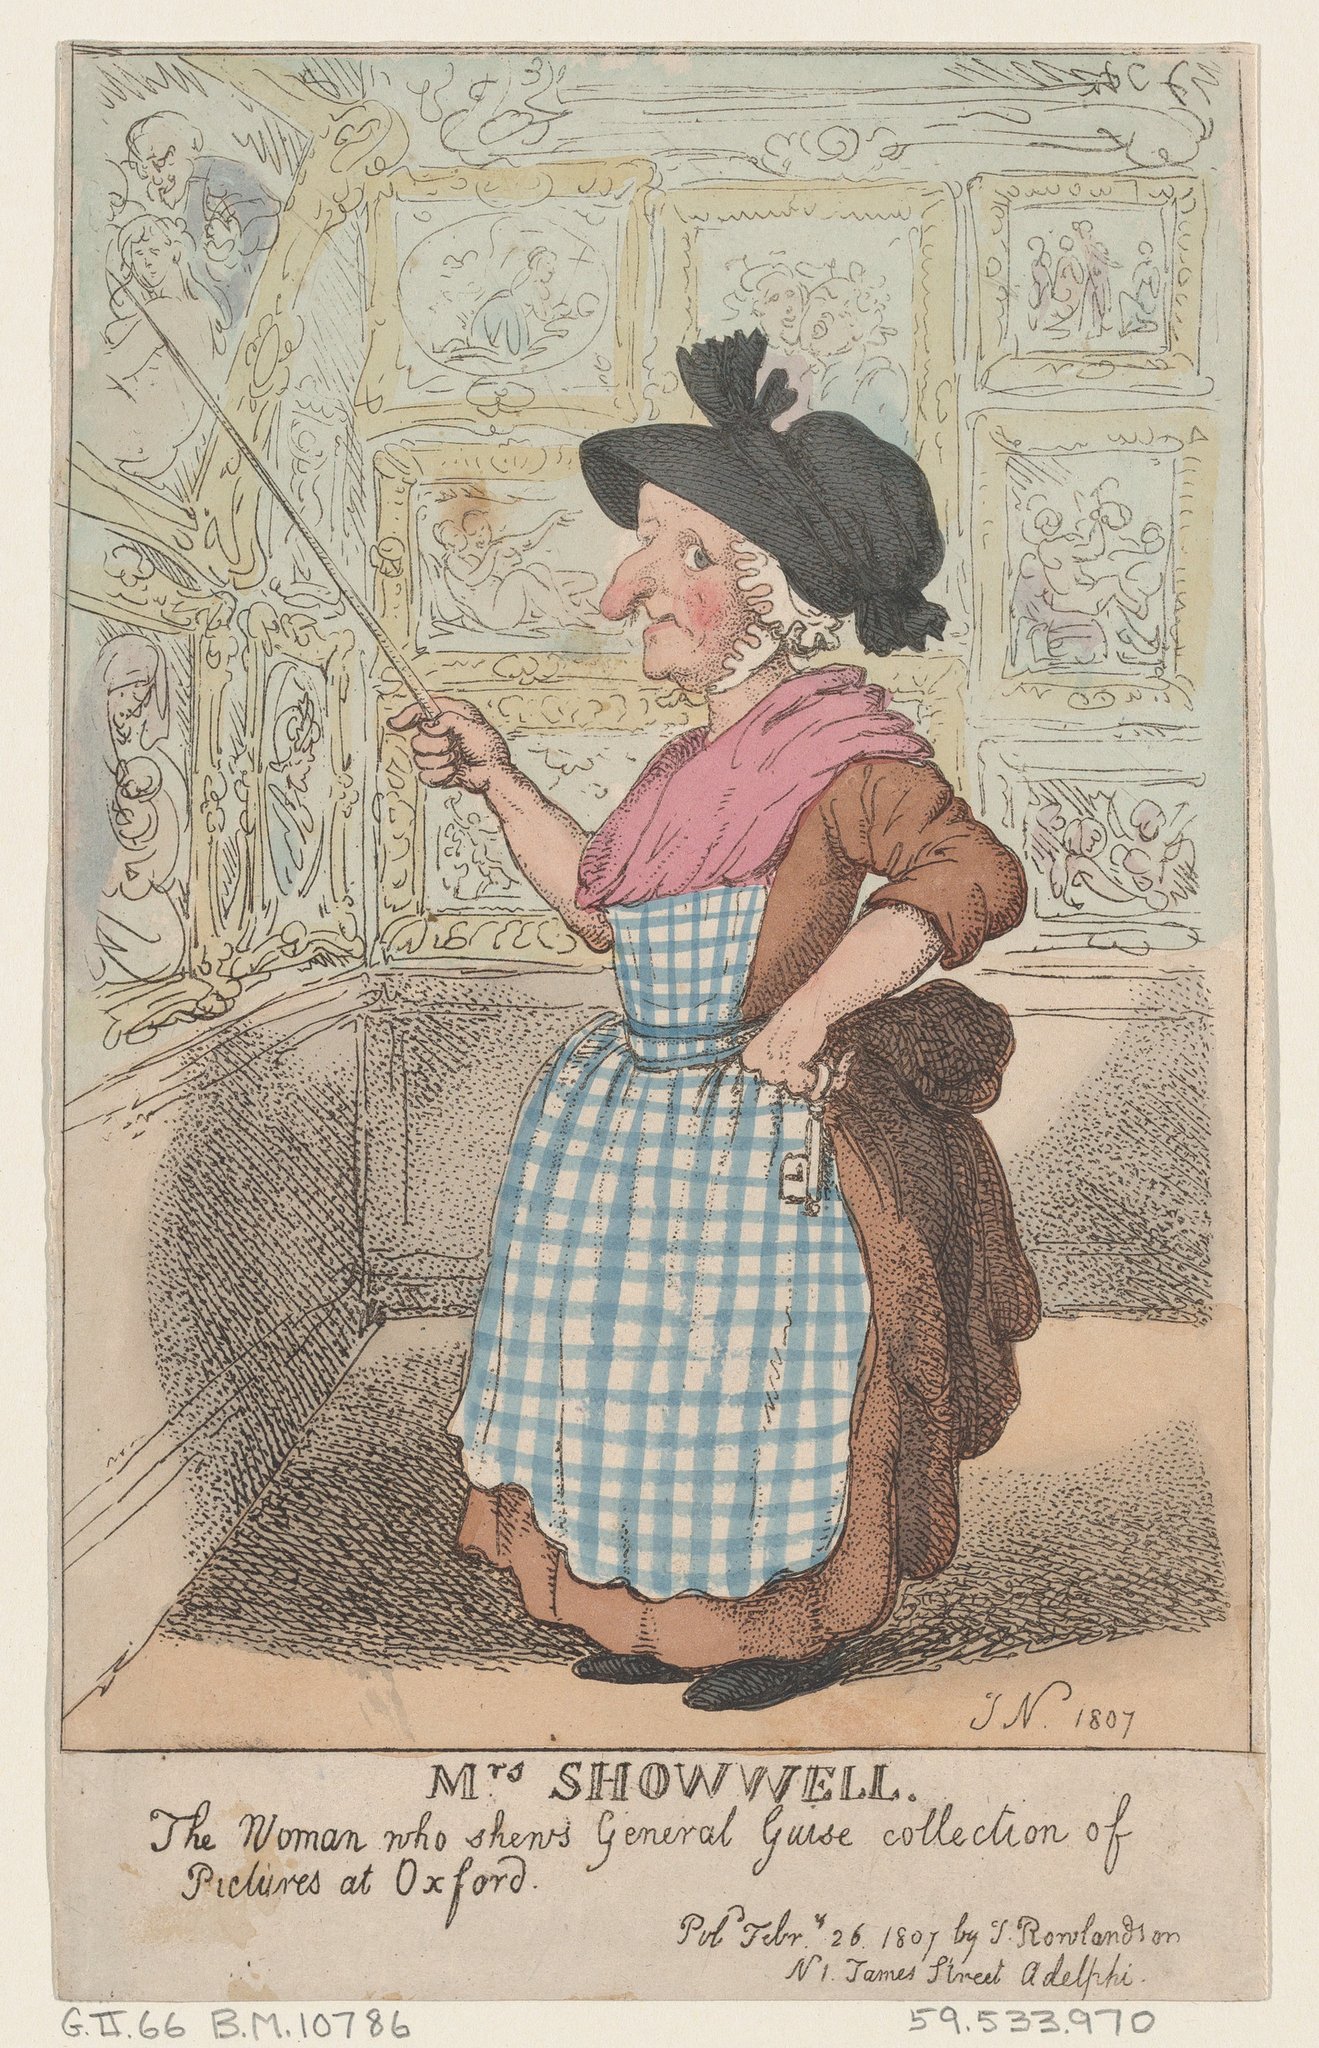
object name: print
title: Mrs. Showell, the Woman who shows General Guise's Collection of Pictures at Oxford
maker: thomas rowlandson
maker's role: artist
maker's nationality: british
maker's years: 1757-1827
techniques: etching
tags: profiles,women